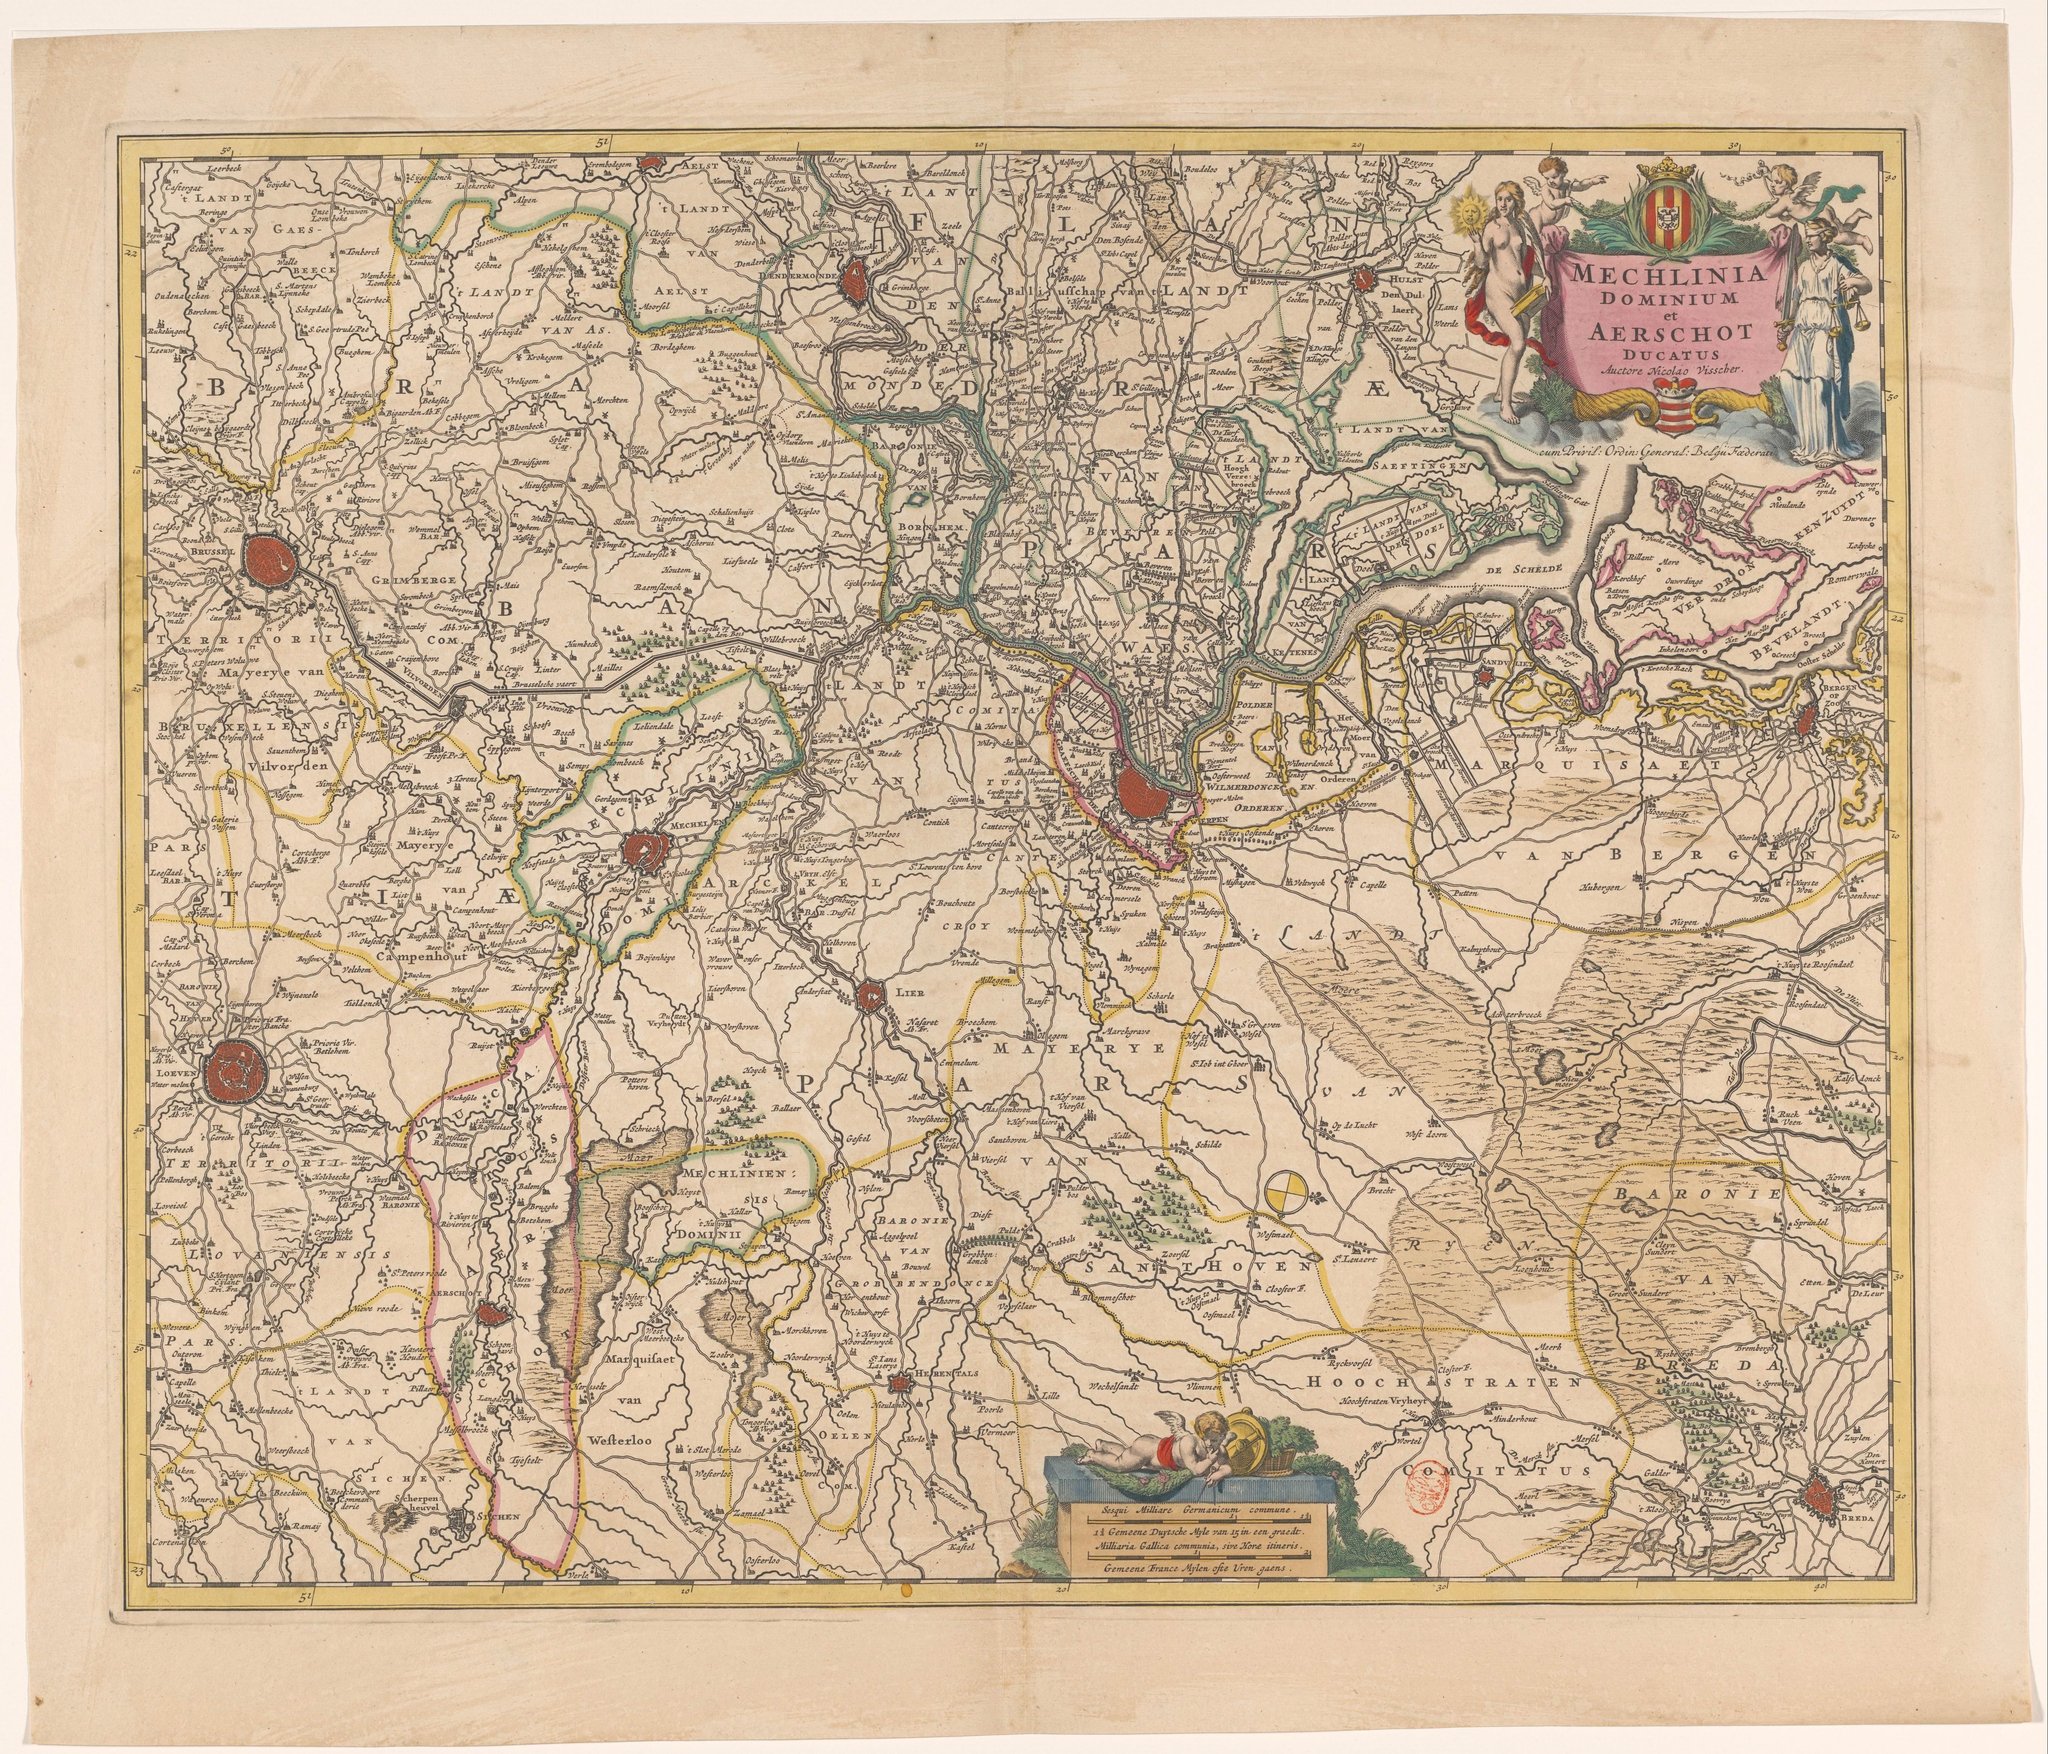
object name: print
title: Kaart van een deel van Vlaanderen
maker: Anonymous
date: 1677-1720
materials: paper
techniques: engraving, etching, hand coloring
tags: coat of arms (as symbol of the state, etc.) (+ city; municipal), maps of separate countries or regions, justitia (justice) as roman personification, truth; 'verità' (ripa), coat of arms (as symbol of the state, etc.) (+ province; provincial), antwerp, mechelen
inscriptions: collector's mark: Lugt 195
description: Kaart van een deel van Vlaanderen, het gebied rond Antwerpen en Mechelen. Rechtsboven de titelcartouche met bovenin het wapen van Mechelen. Links van de cartouche een allegorie van de waarheid, rechts Justitia. Onder, rechts van het midden, een cartouche met twee schaalstokken: 1 1/2 Gemeene Duytsche Myle van 15 in een graedt / 2 Gemeene France Mylen ofte Uren Gaens. De kaart is voorzien van een gradenverdeling langs de randen.